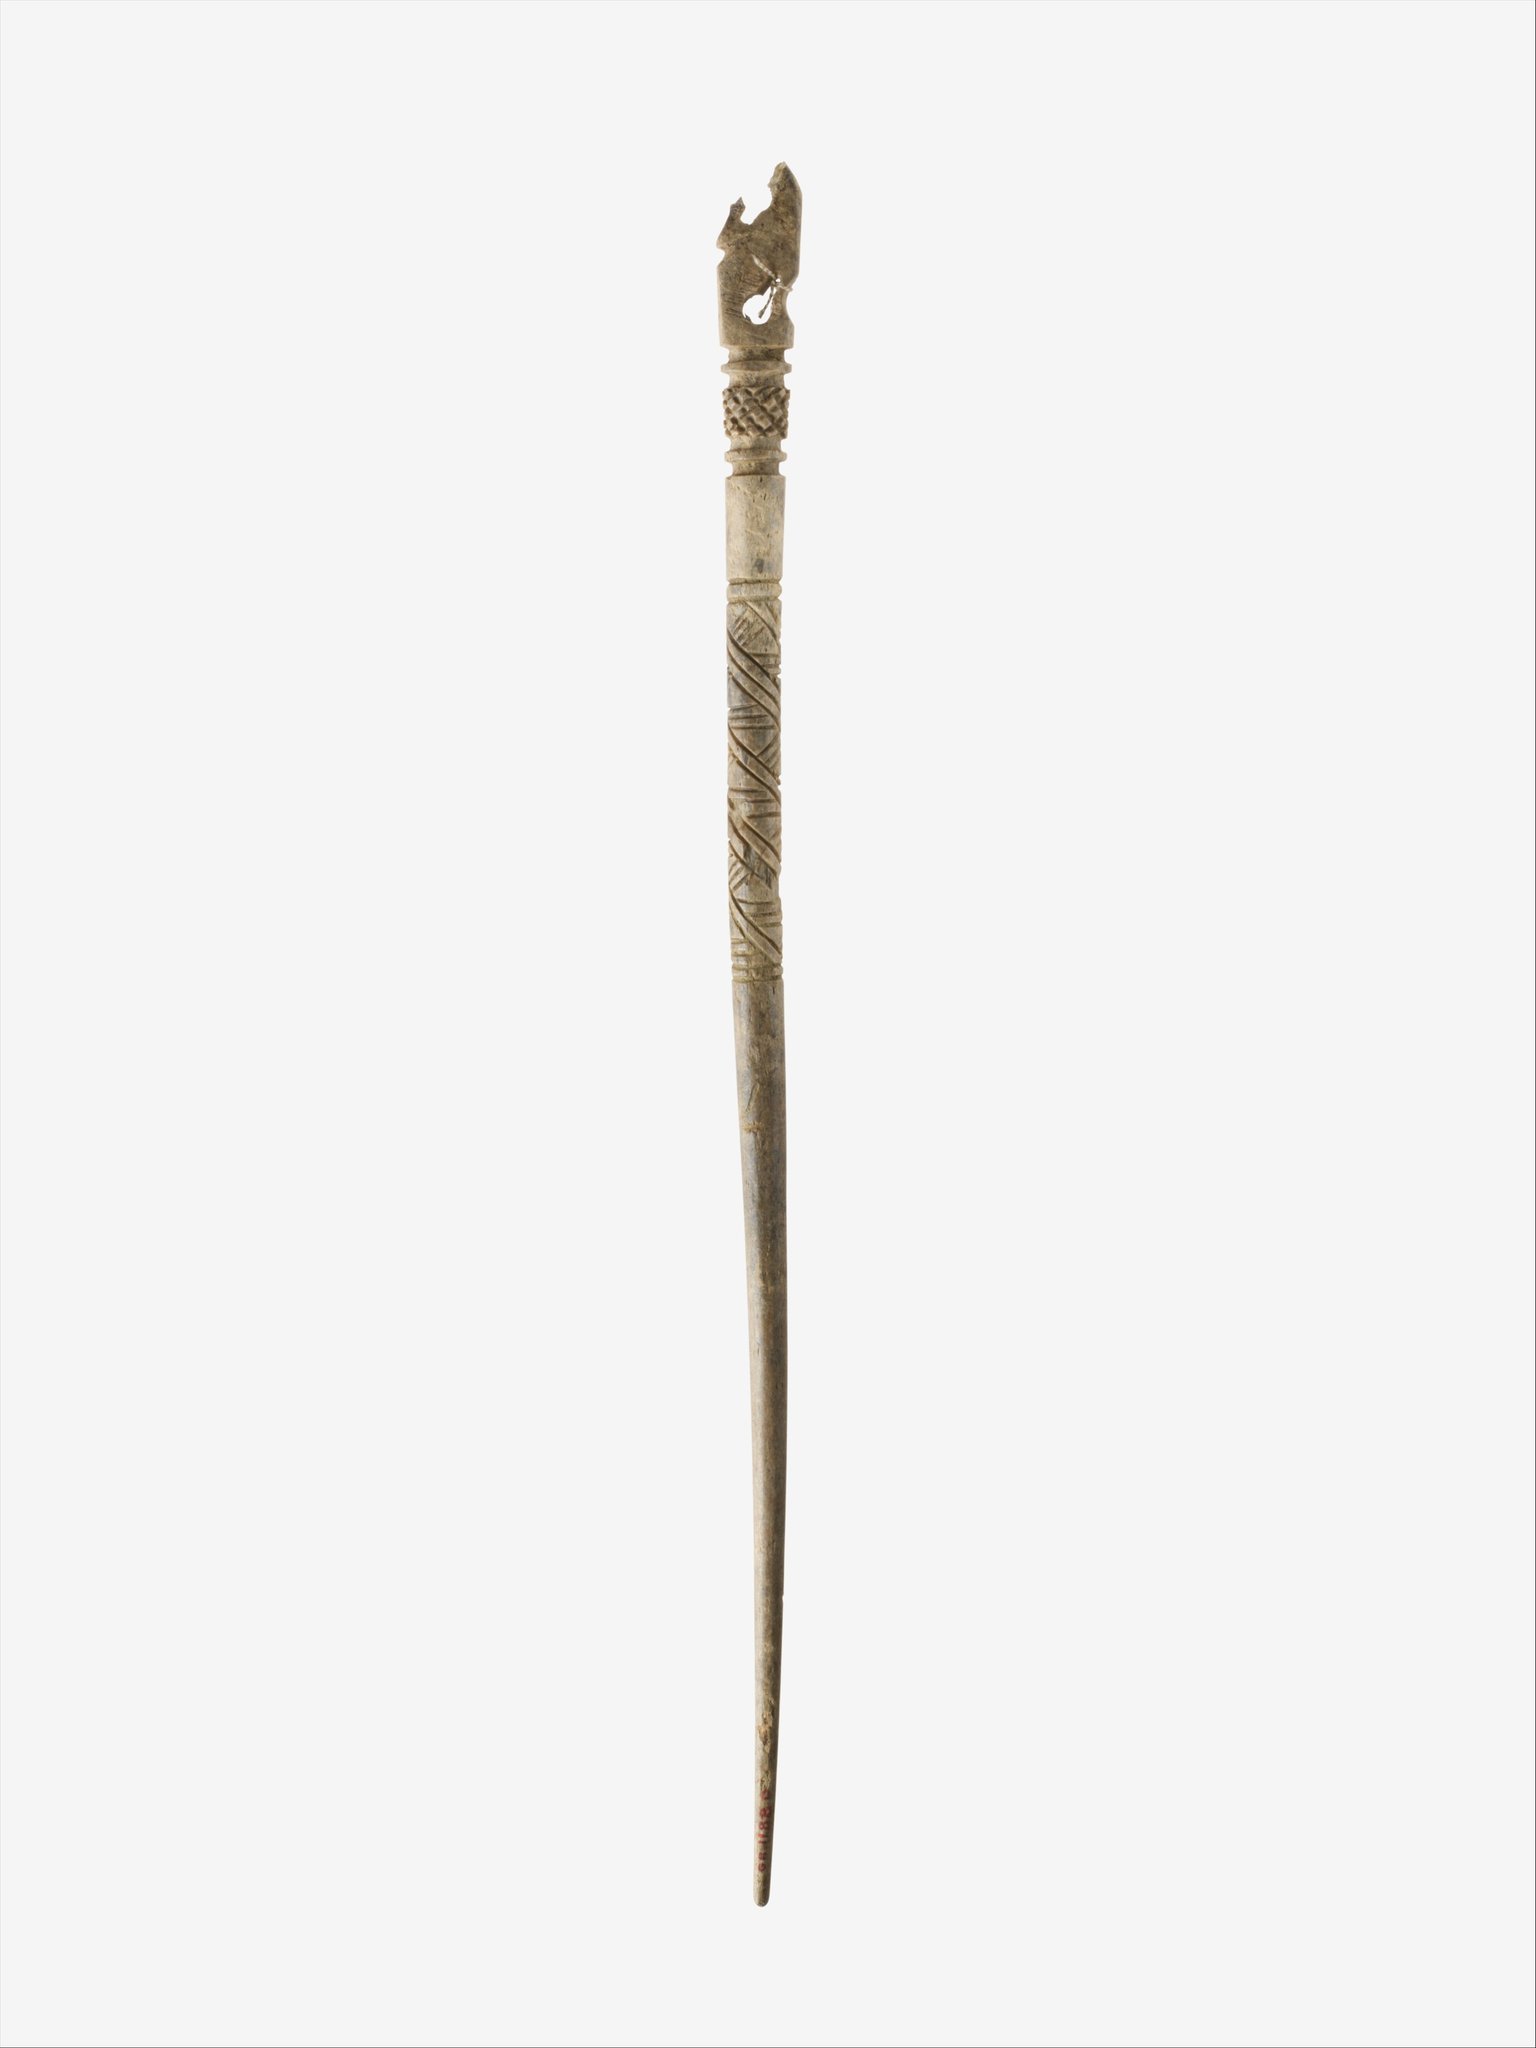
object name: stylus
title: Bone pin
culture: roman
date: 34-300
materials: bone, ivory